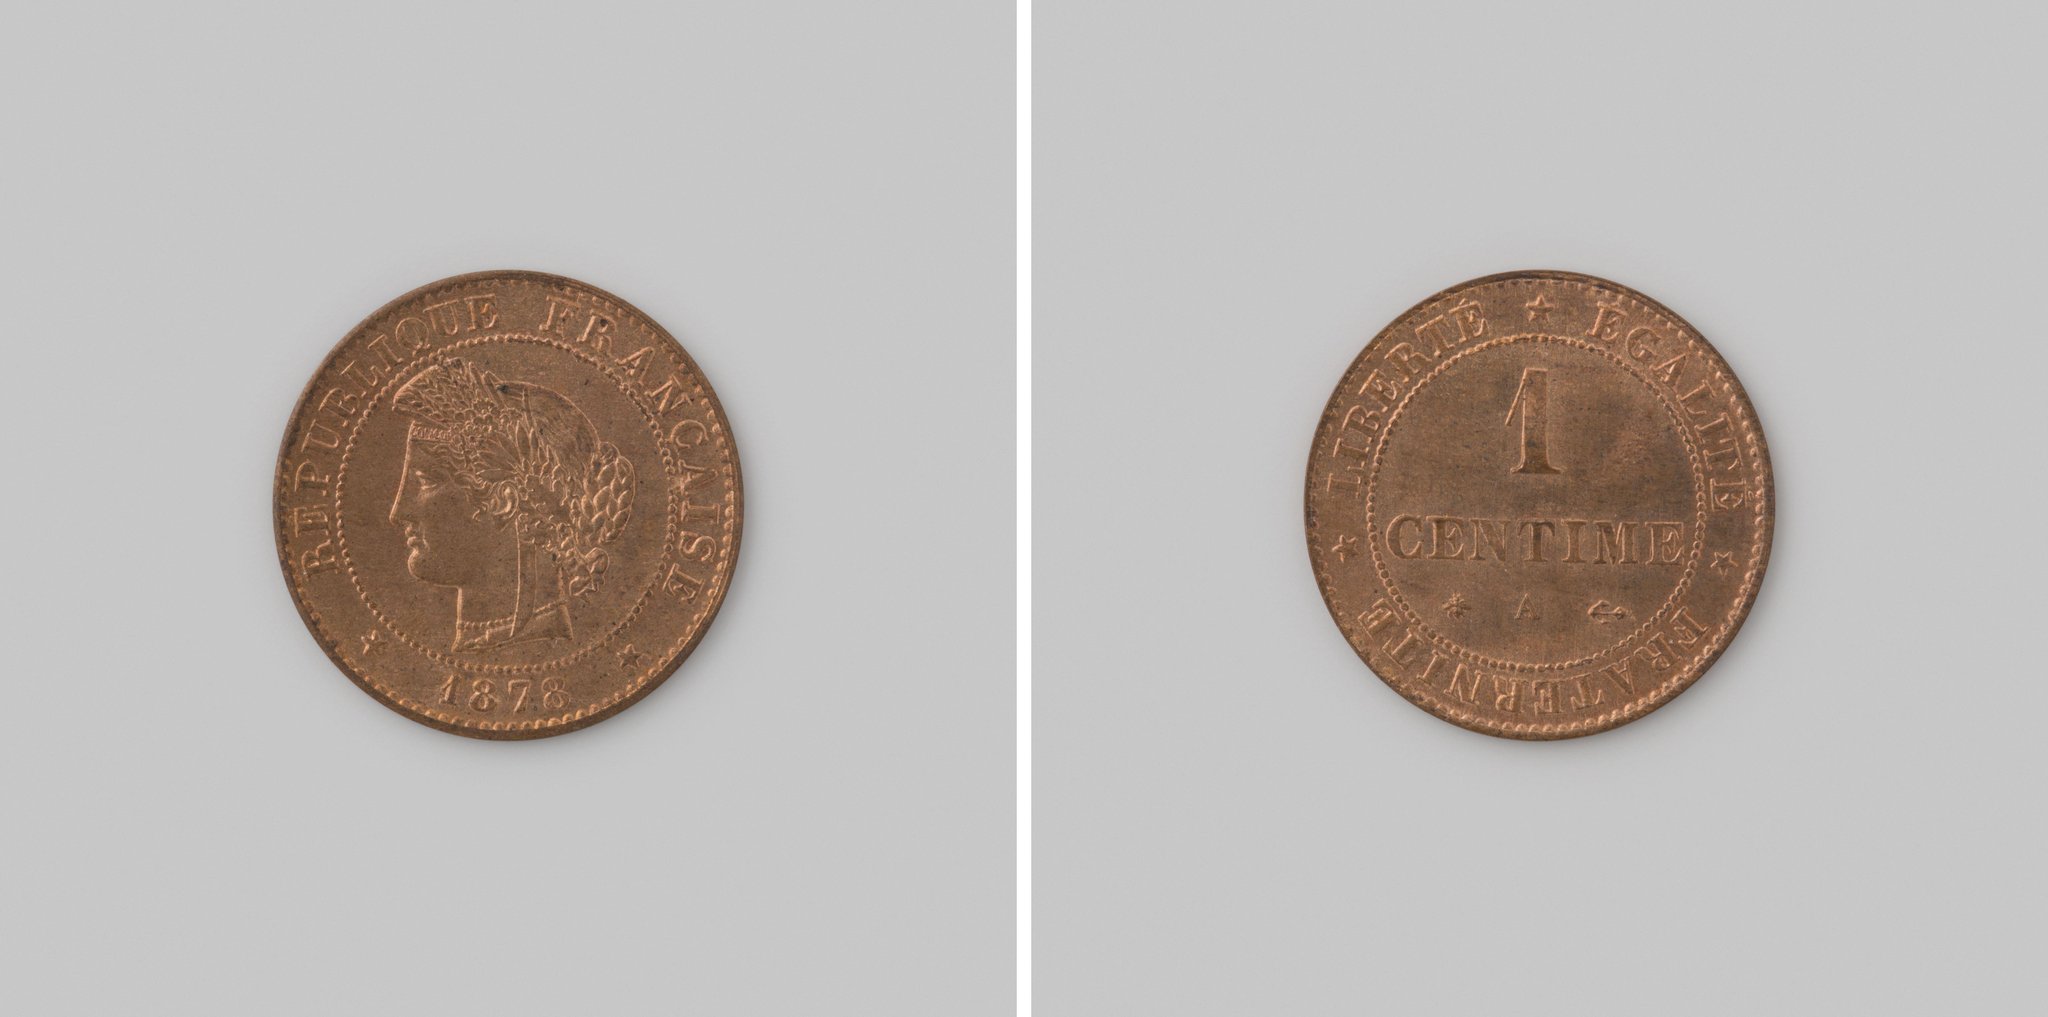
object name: centime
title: Frankrijk, Derde Republiek, centime,1878 A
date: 1878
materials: bronze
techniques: striking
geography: paris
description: Bronzen munt. Voorzijde: portret van een vrouw met krans en diadeem naar links.Jaartal onderaan. Keerzijde: binnen twee samengebonden takken waarde-aanduiding in twee regels, waaronder de letter A [=Parijs]. Gladde rand.